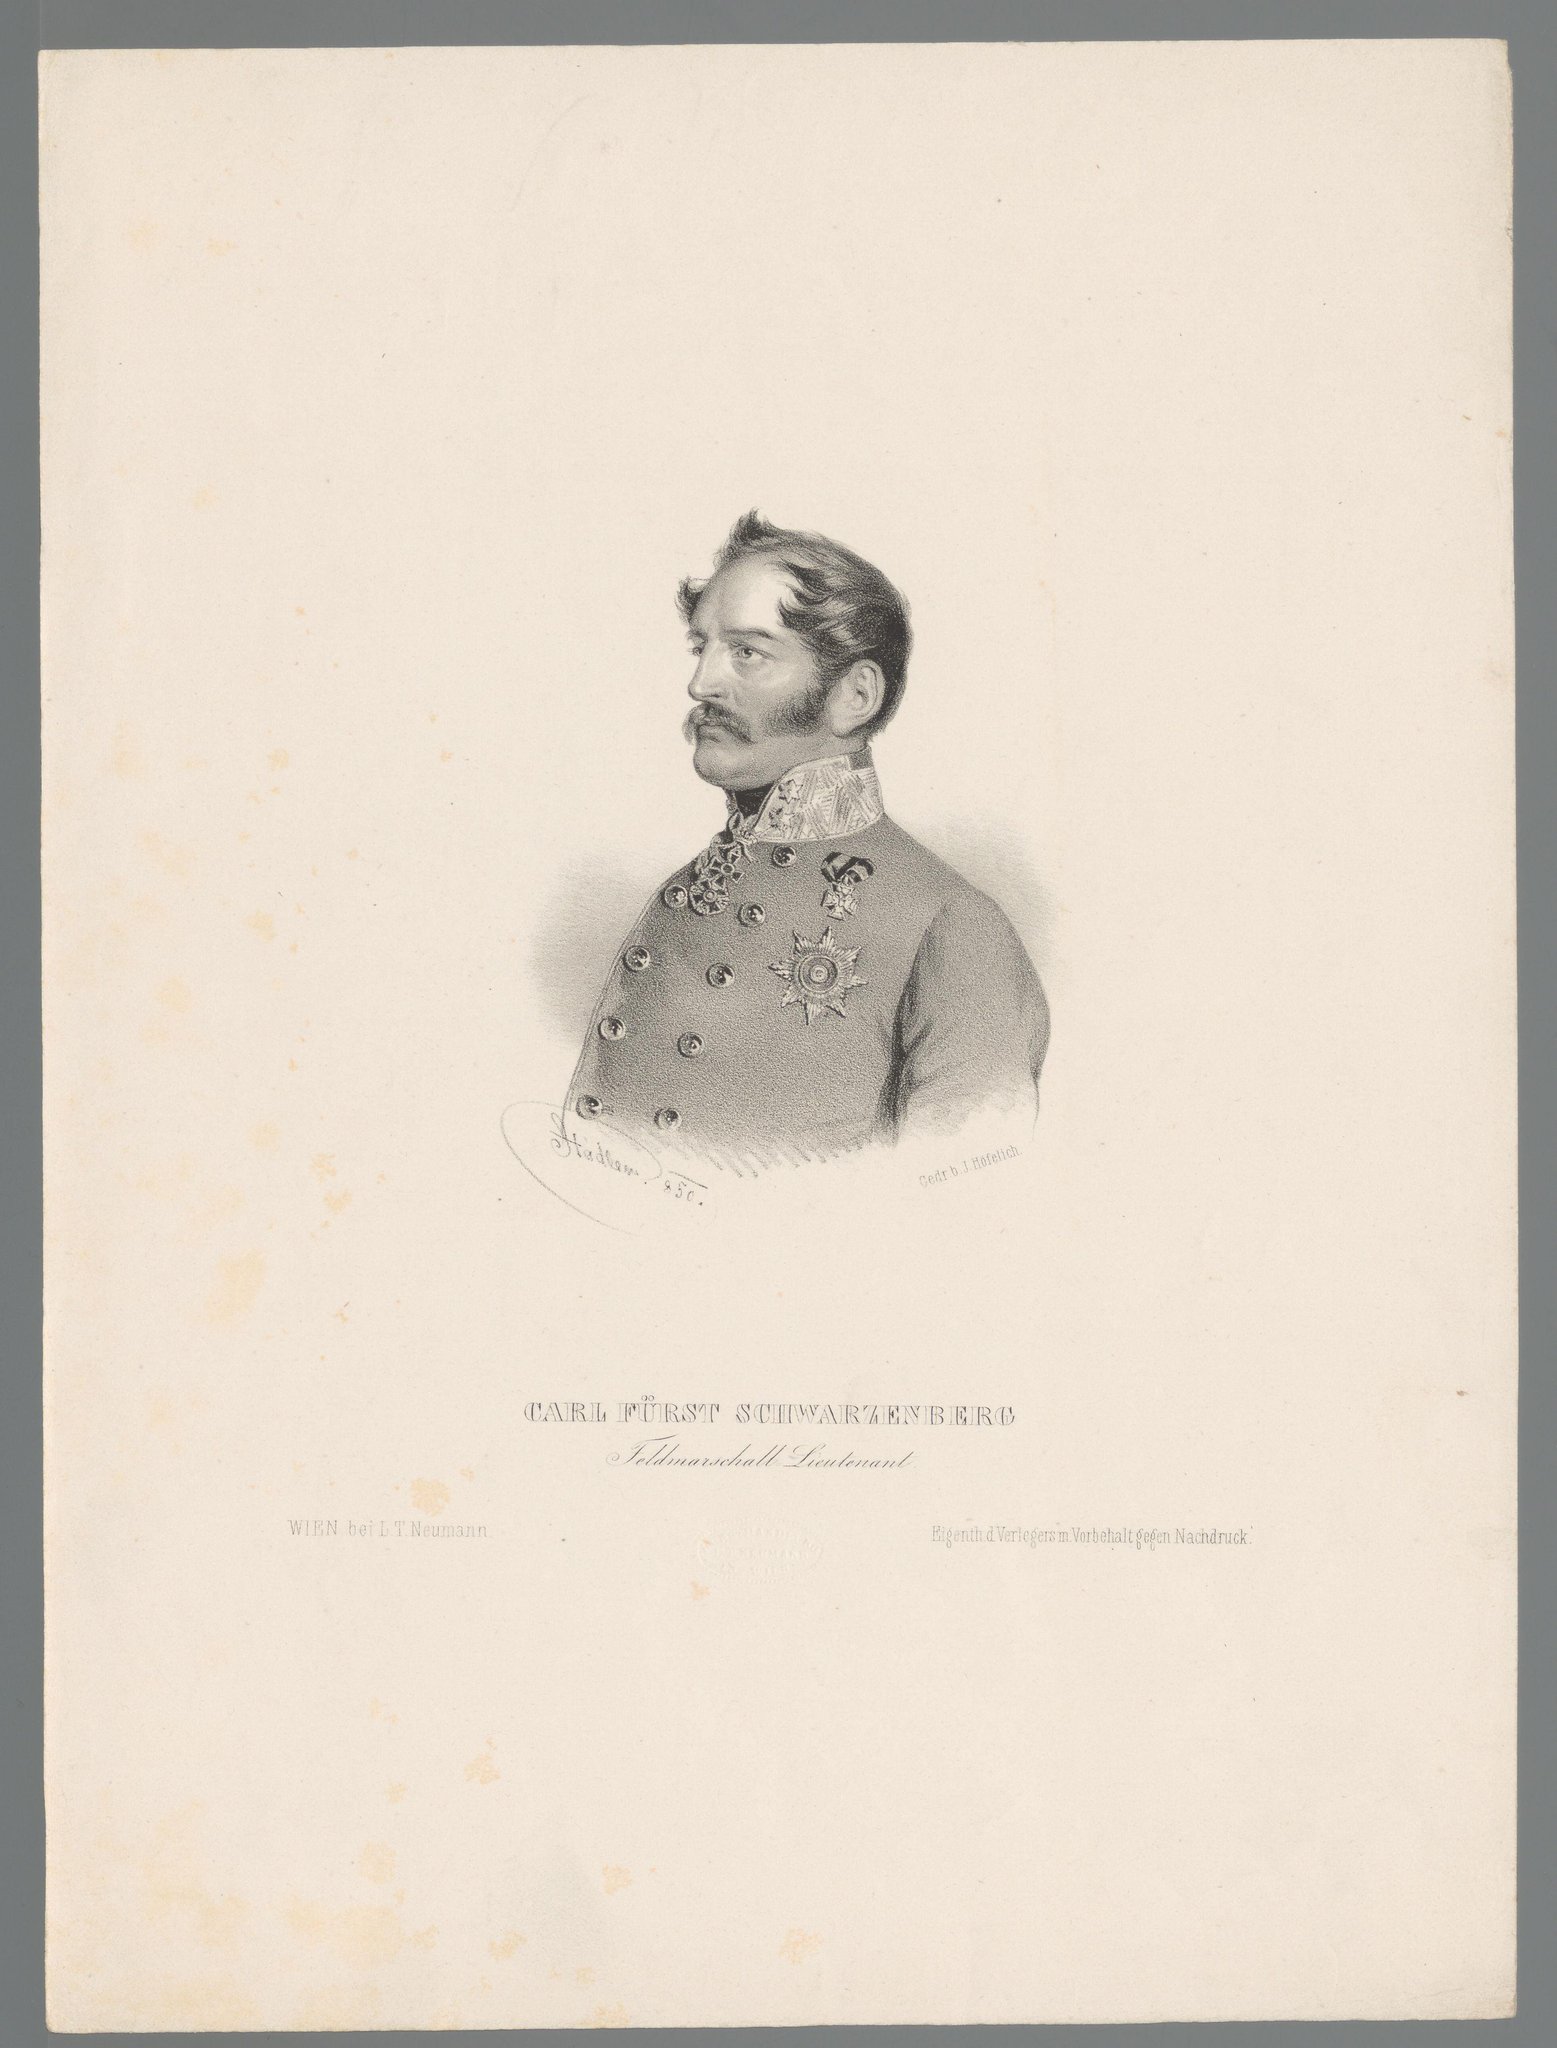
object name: print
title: Carl Fürst Schwarzenberg, Feldmarschall Lieutenant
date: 1850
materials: paper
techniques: lithograph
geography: vienna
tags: politician, moustache, adult man, historical persons, (military) uniforms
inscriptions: collector's mark: Lugt 2228, check stamp: ‘Kunsthandlung L.T. Neumann in Wien’